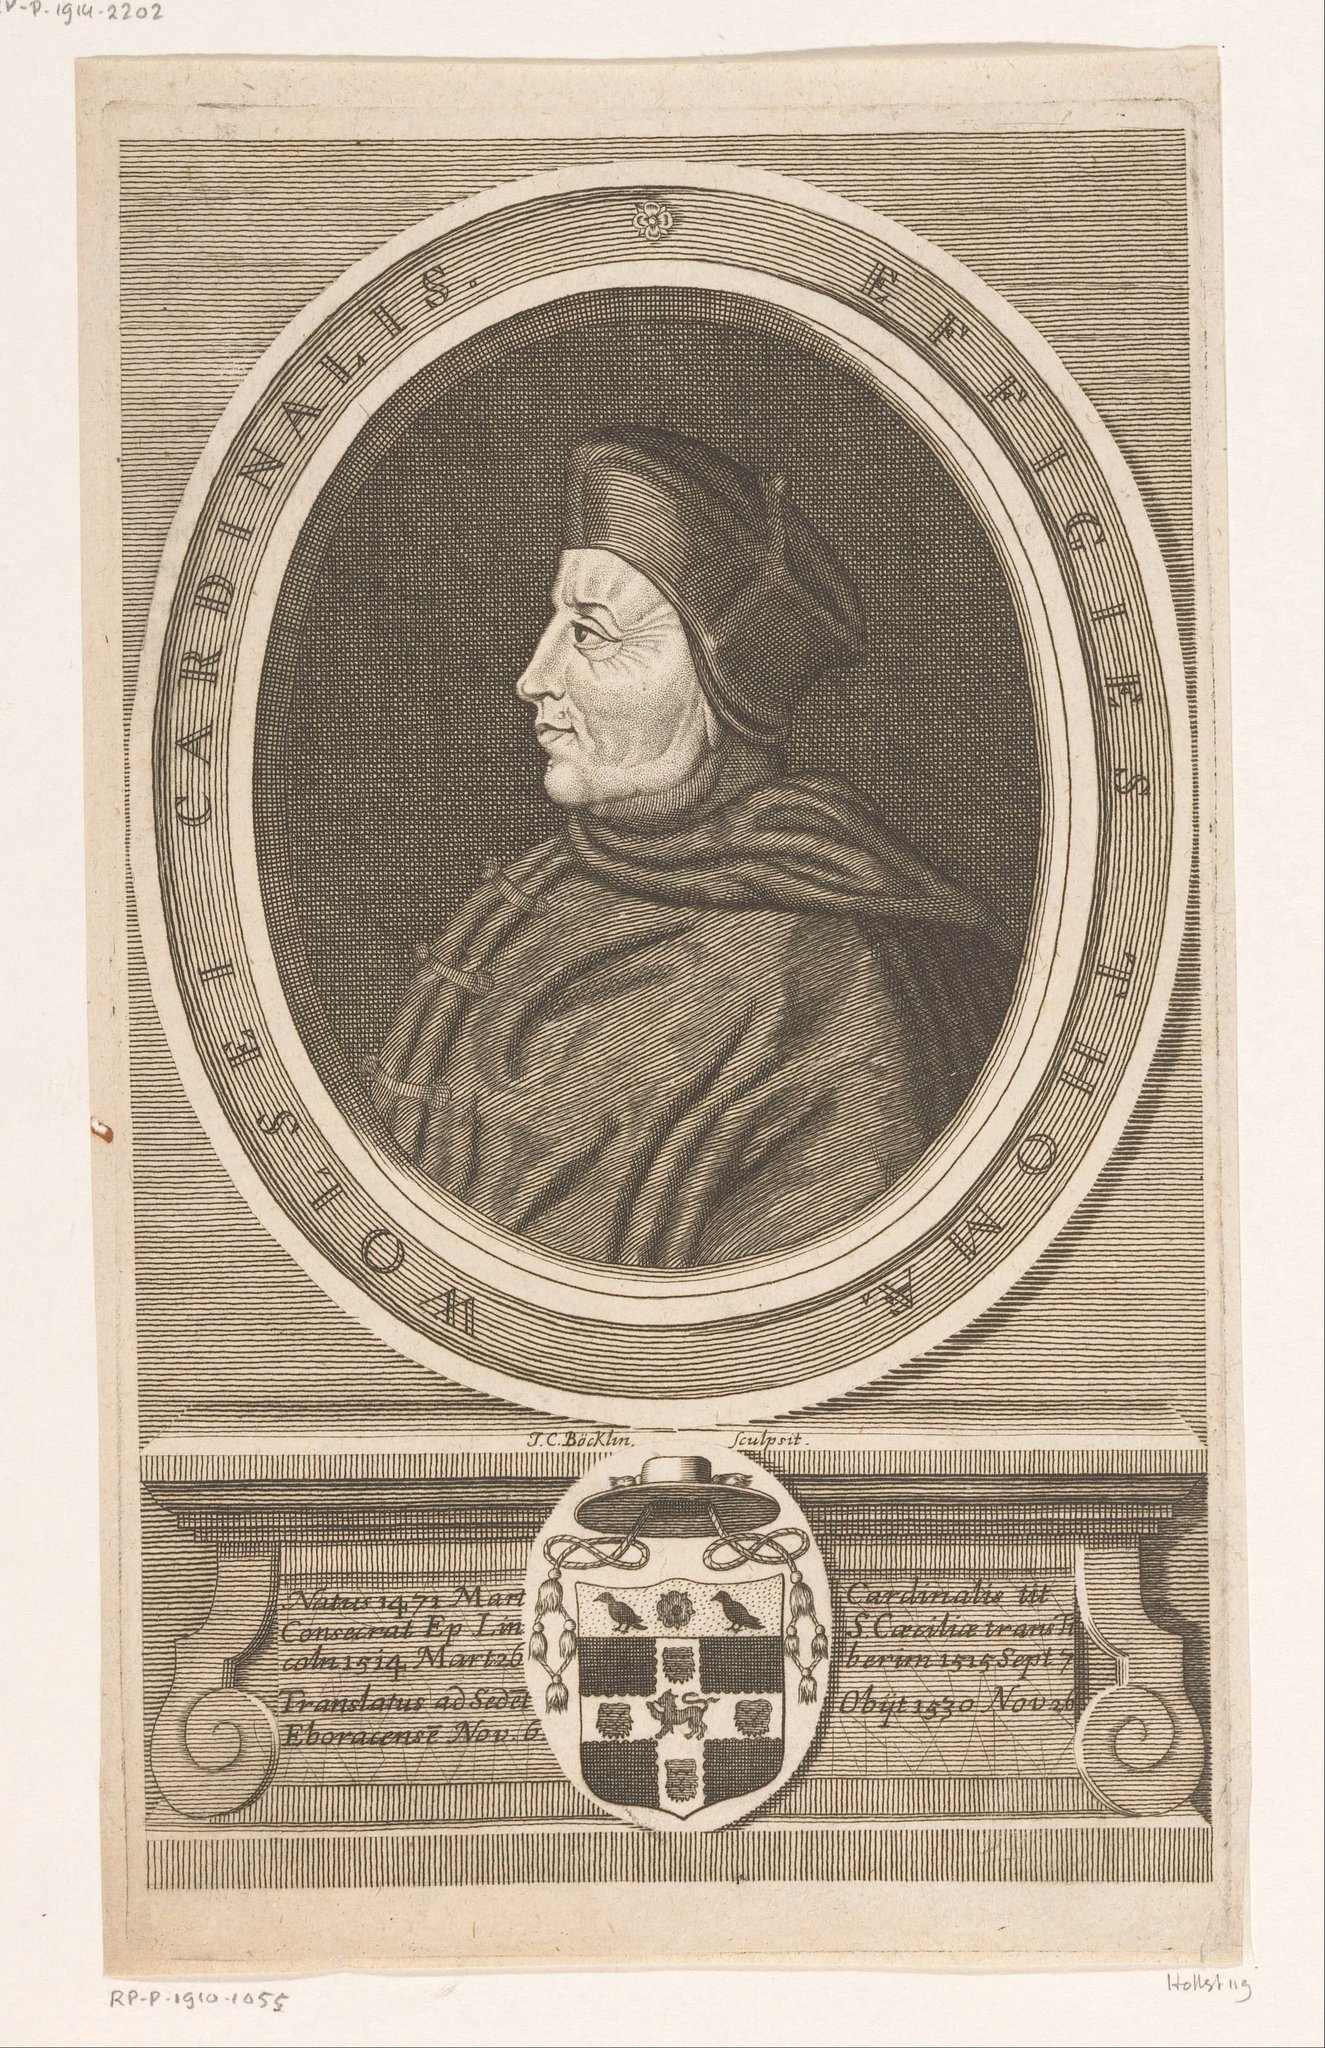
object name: print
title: Portret van Thomas Wolsey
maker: johann christoph boecklin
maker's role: print maker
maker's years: 1657-1709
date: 1667-1709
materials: paper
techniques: engraving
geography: leipzig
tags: historical persons, armorial bearing, heraldry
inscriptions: collector's mark: Lugt 2228